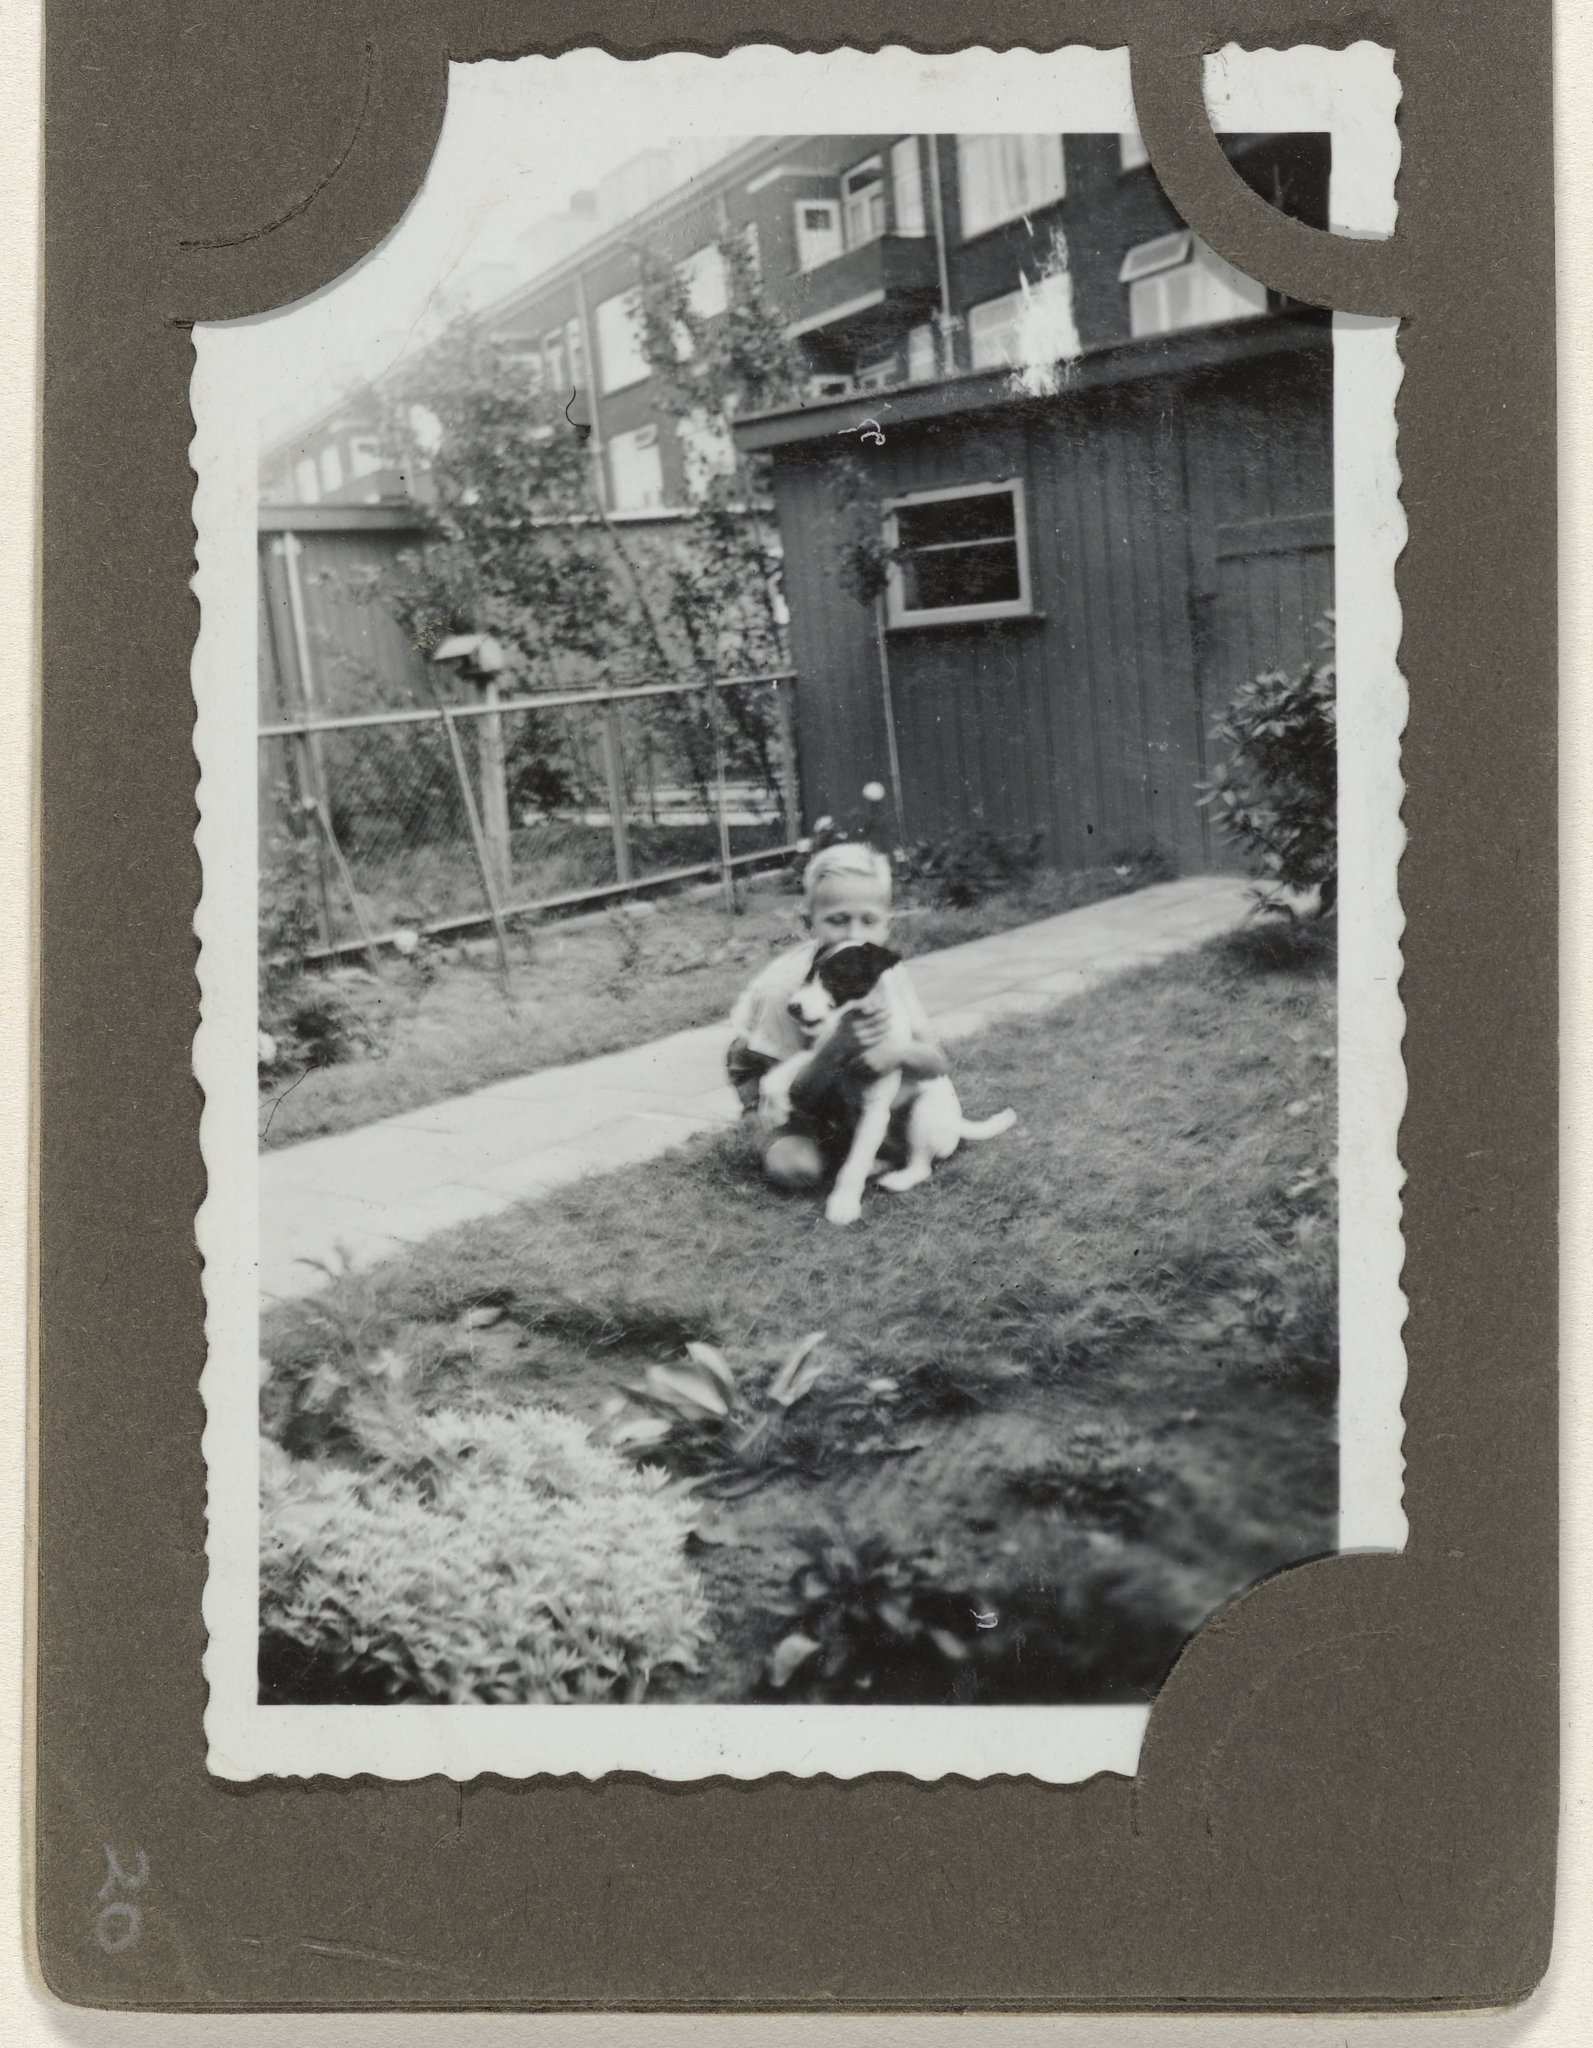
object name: photograph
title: Jongen met hond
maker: Anonymous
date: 1933-1944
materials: photographic support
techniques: gelatin silver print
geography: rotterdam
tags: wim van den bosch, rotterdam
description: Jongen met blond haar, met een hond in de tuin achter een woning. Onderdeel van het familiealbum 1933-1944.